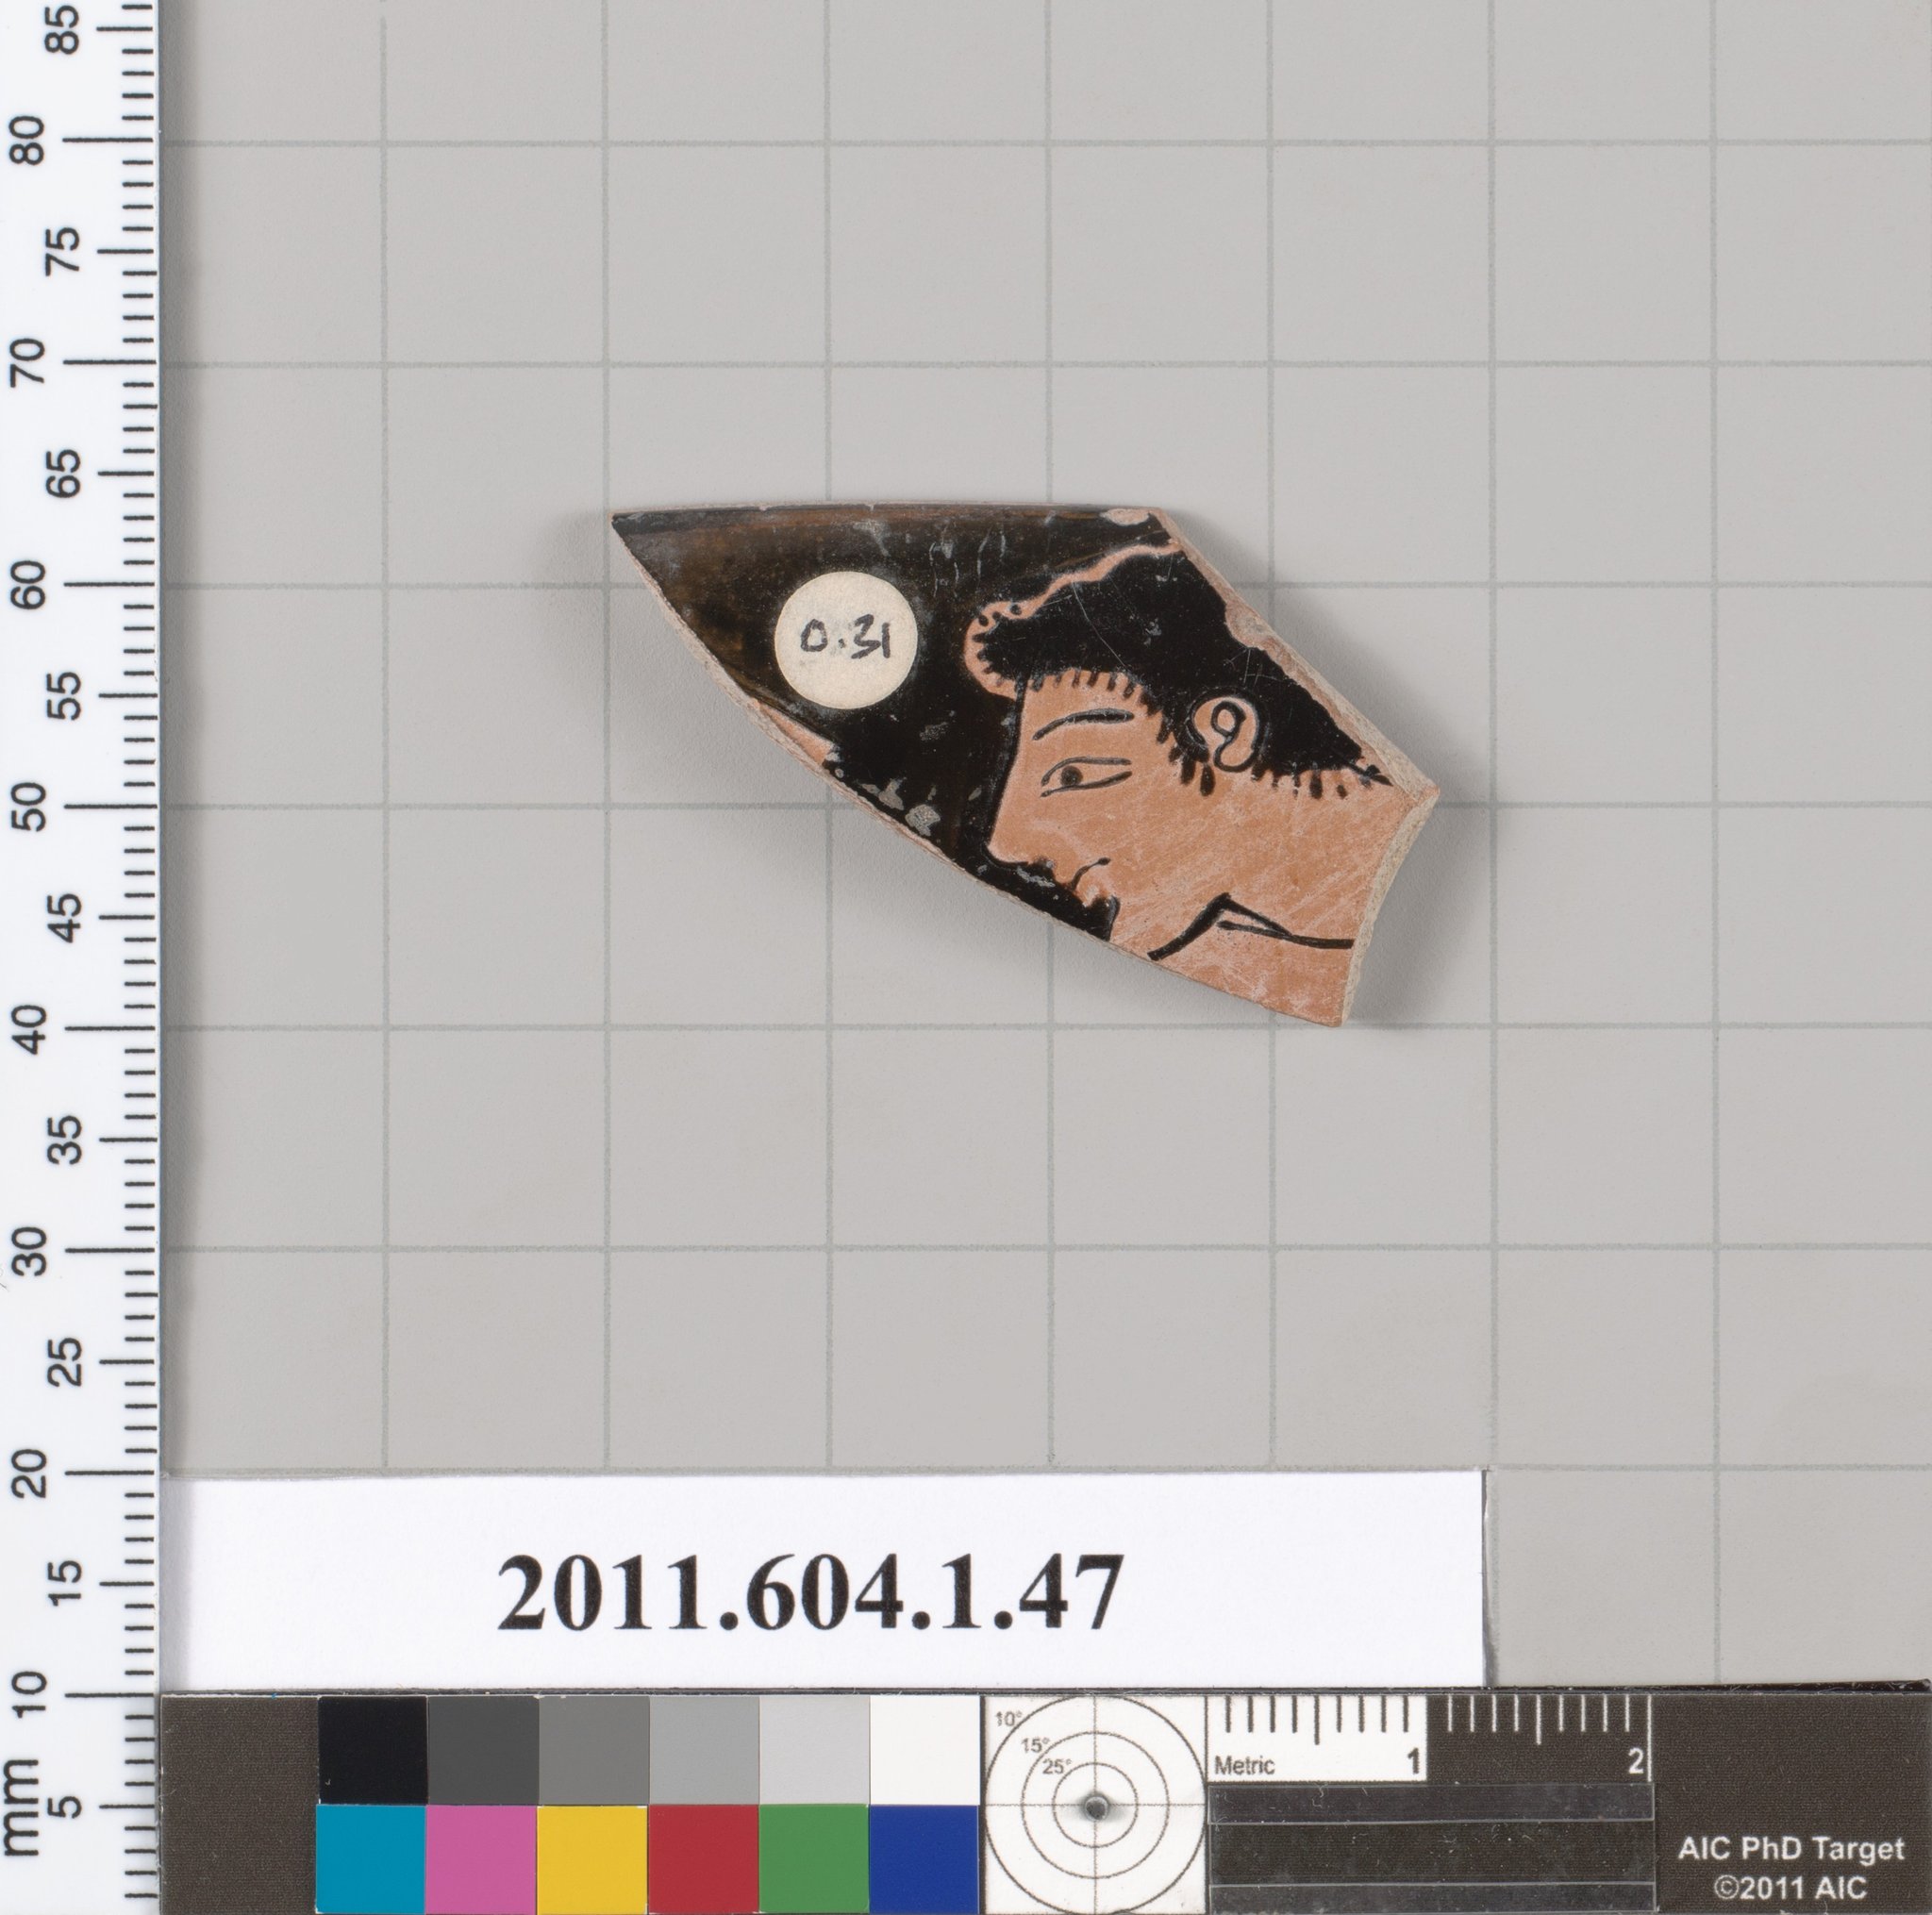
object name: kylix fragment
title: Terracotta rim fragment of a kylix (drinking cup)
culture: greek, attic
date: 490 BCE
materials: terracotta